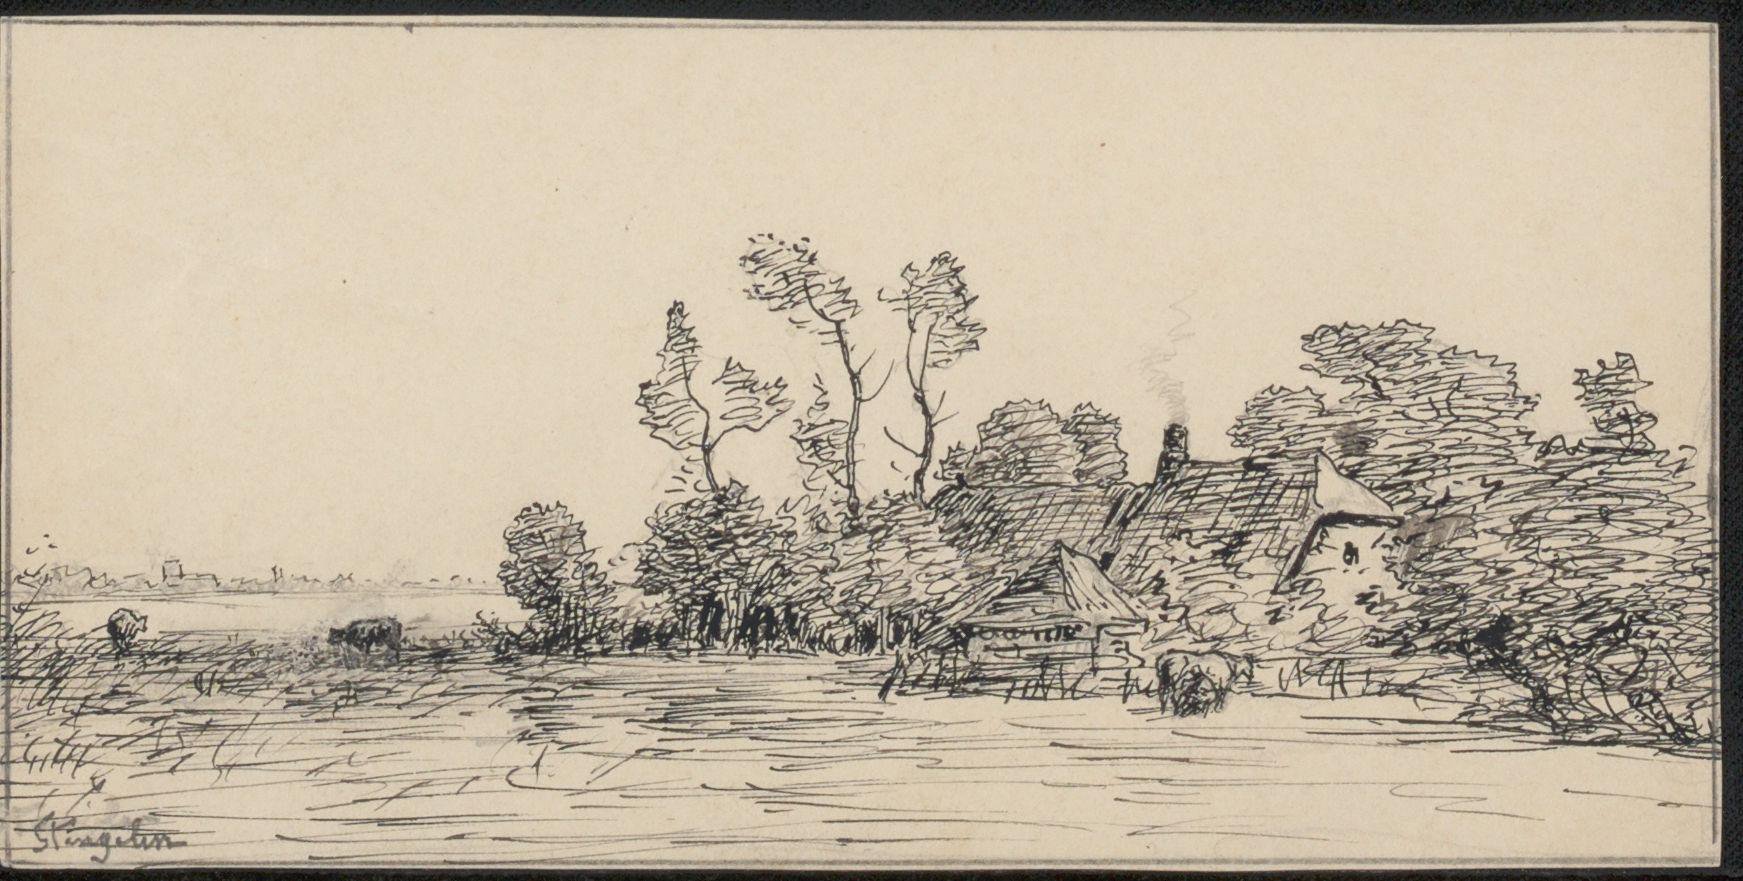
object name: drawing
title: Tekening uit archief Philip Zilcken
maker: alphonse stengelin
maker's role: painter, print maker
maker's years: 1852-1938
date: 1923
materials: ink, paper, pencil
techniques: pen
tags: draughtsman, philip zilcken, farm or solitary house in landscape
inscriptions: annotation: ‘Stengelin van KW’, collector's mark: ‘RPK’, signature: ‘Stengelin’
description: Tekening is verstuurd als bijlage bij brief RP-D-1982-43-STENGELIN-46.